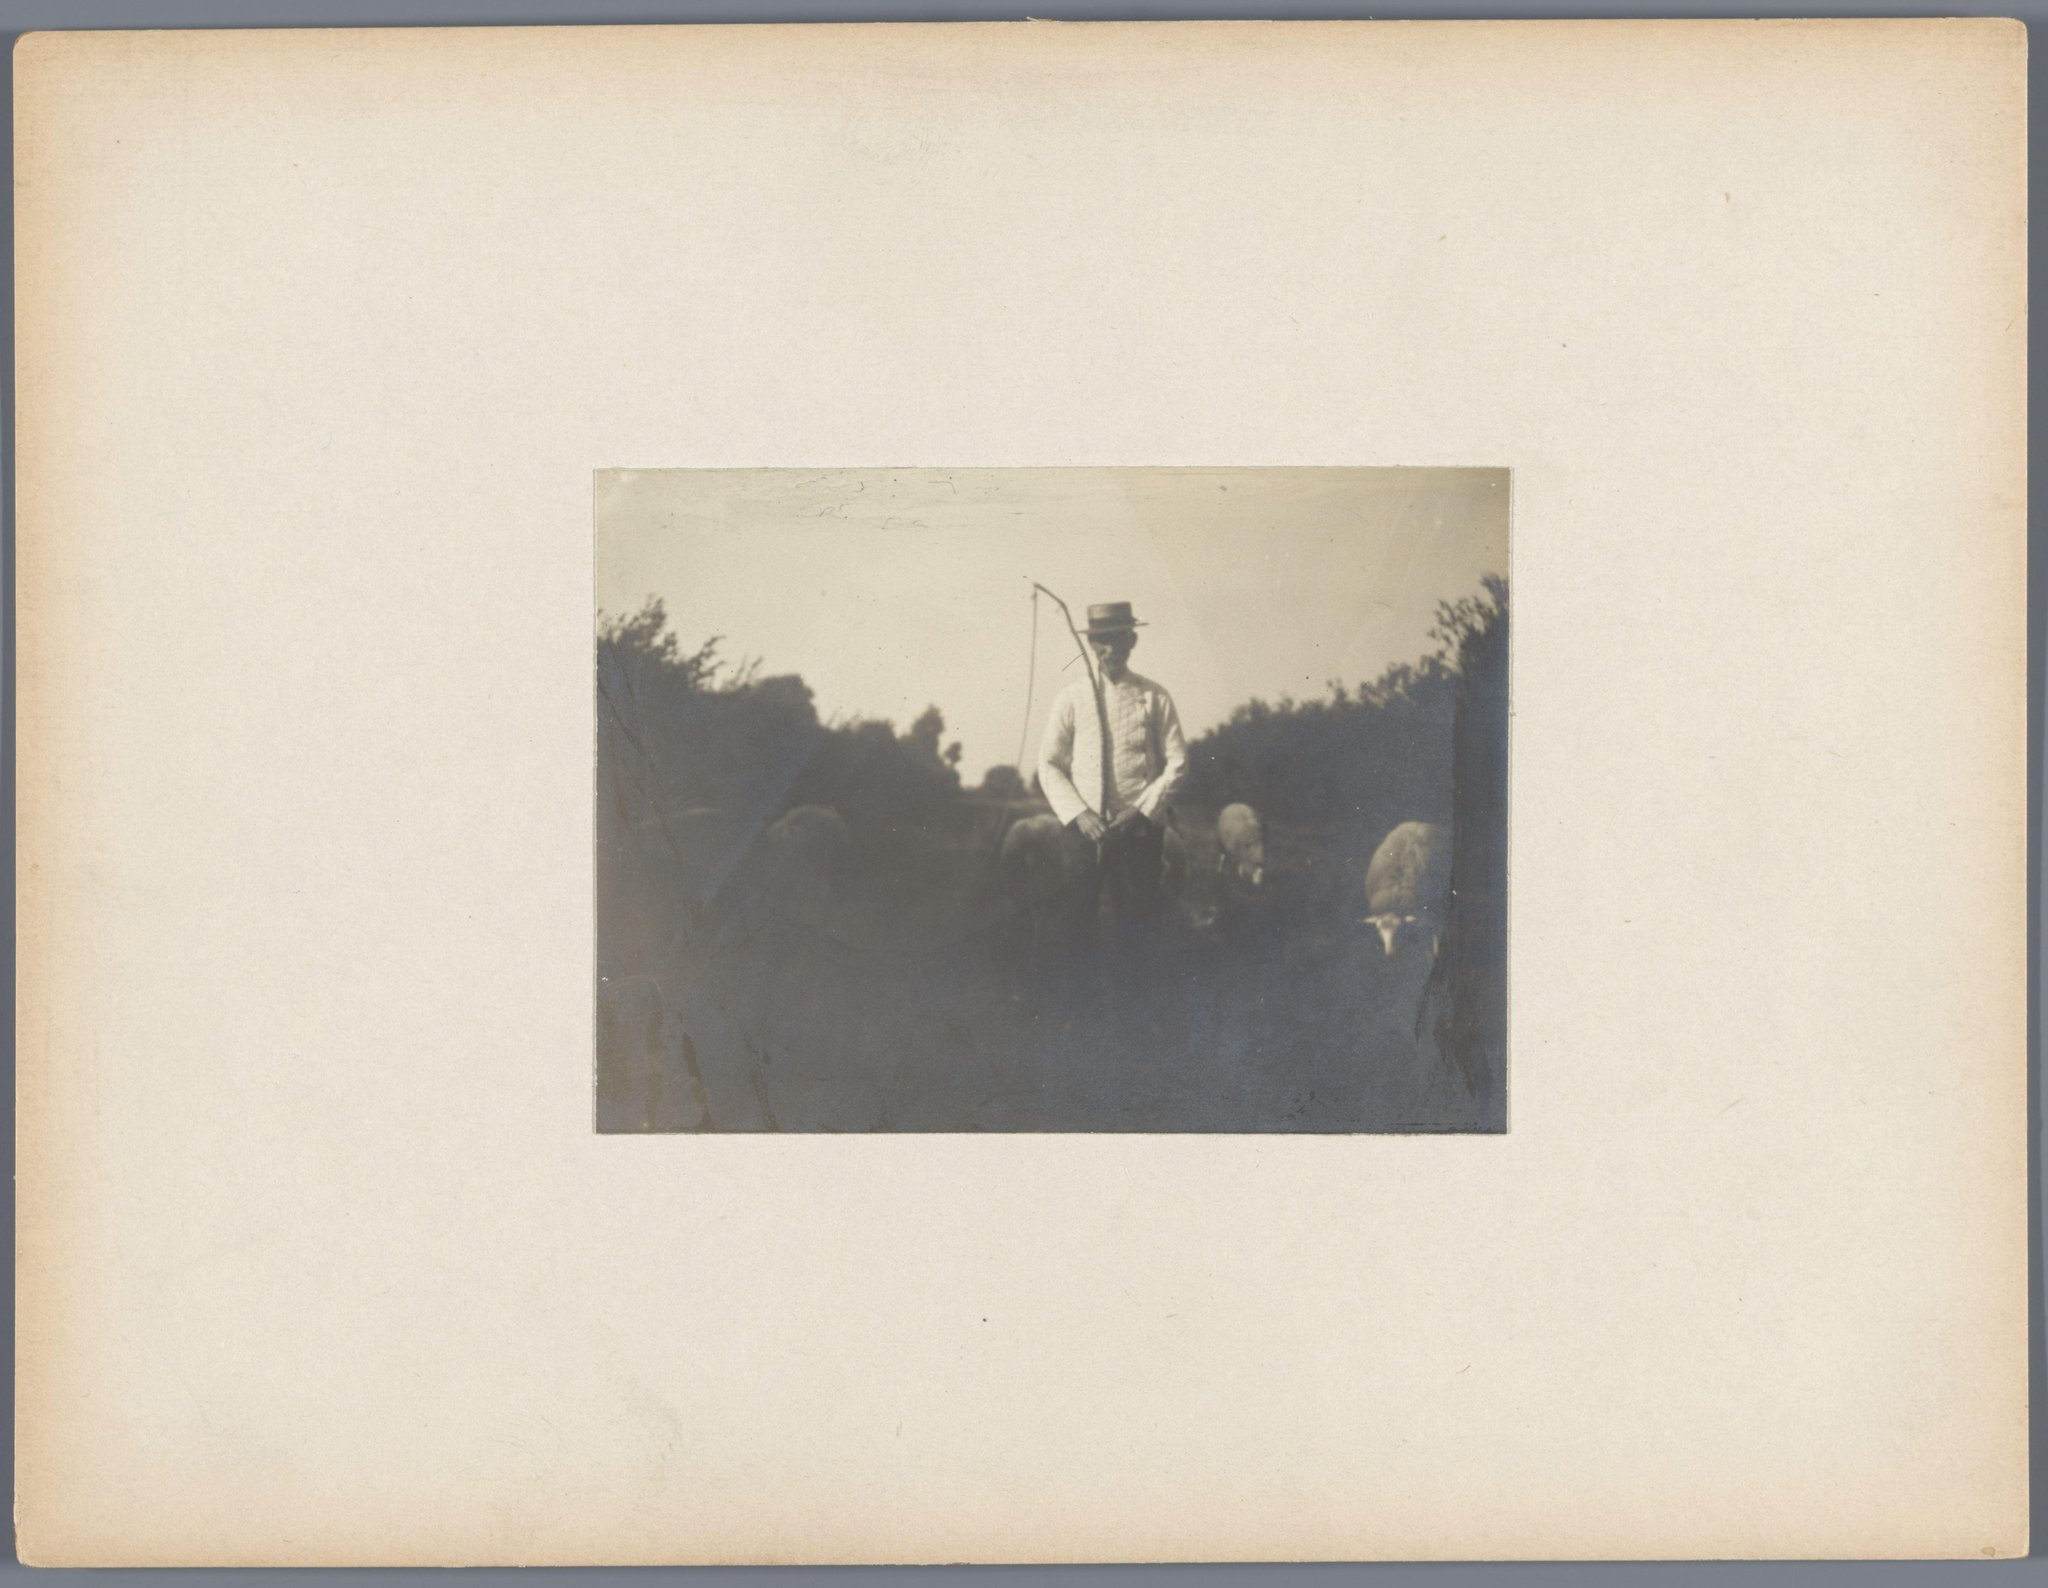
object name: photograph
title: Man in witte jas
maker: Anonymous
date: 1907-1910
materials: cardboard, photographic support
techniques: gelatin silver print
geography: netherlands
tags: netherlands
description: Man in witte jas, mogelijk een koetsier of een hengelaar. Onderdeel van het losbladige fotoalbum met 39 foto's van een reis door Nederland, ca. 1907-1910.